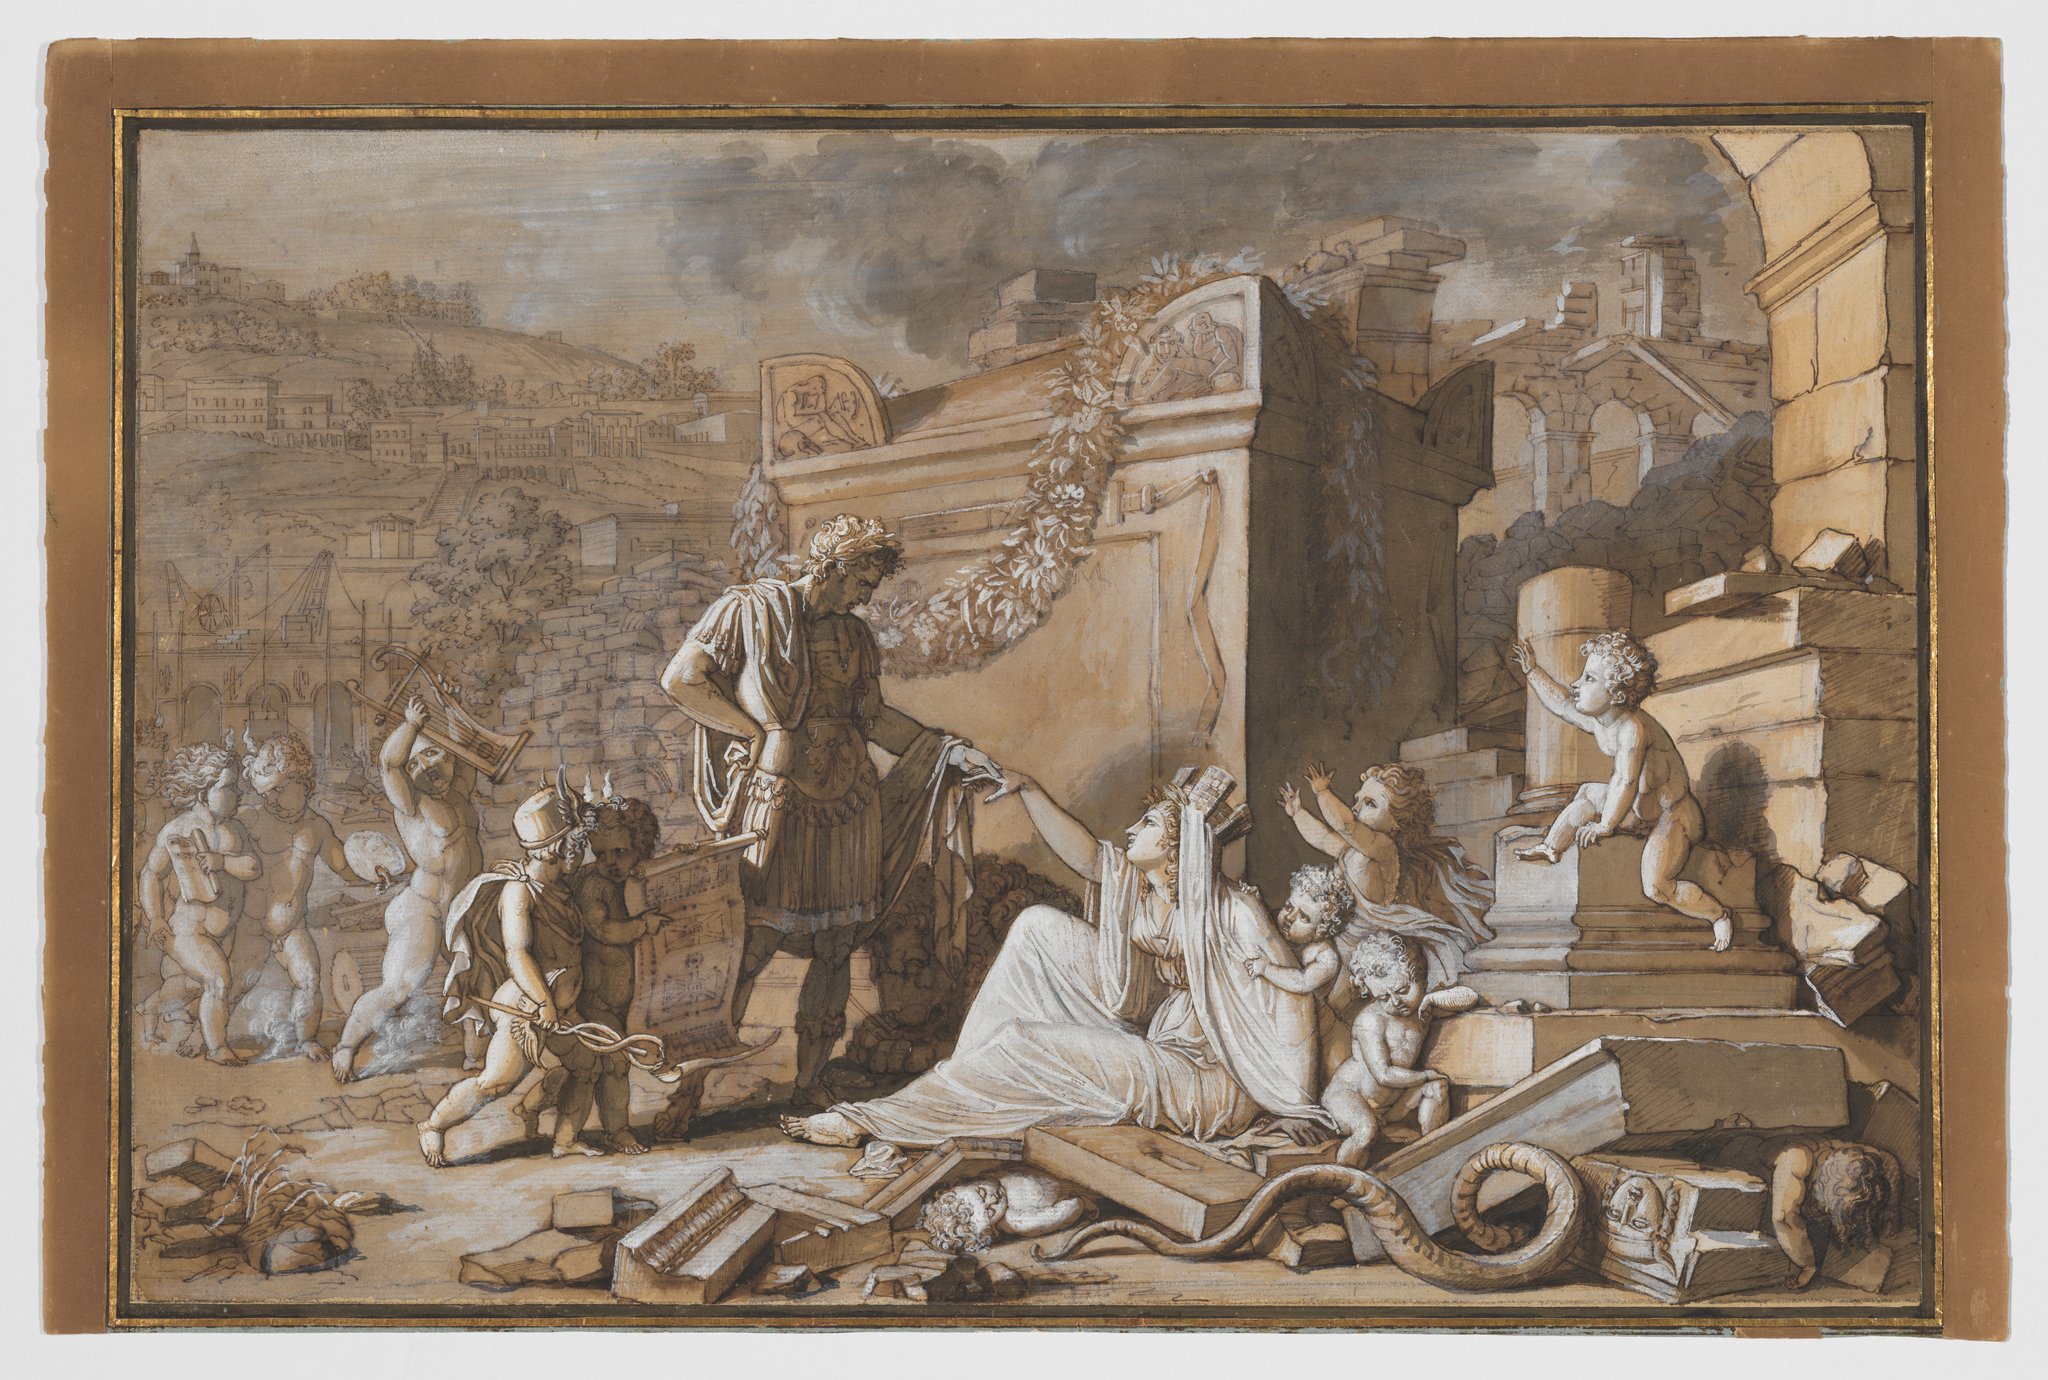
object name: drawing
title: Bonaparte reviving the city of Lyon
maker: pierre henri revoil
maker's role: artist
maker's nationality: french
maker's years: 1776-1842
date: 1800-1804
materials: chalk, gouache, ink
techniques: brush, heightening, pen, wash